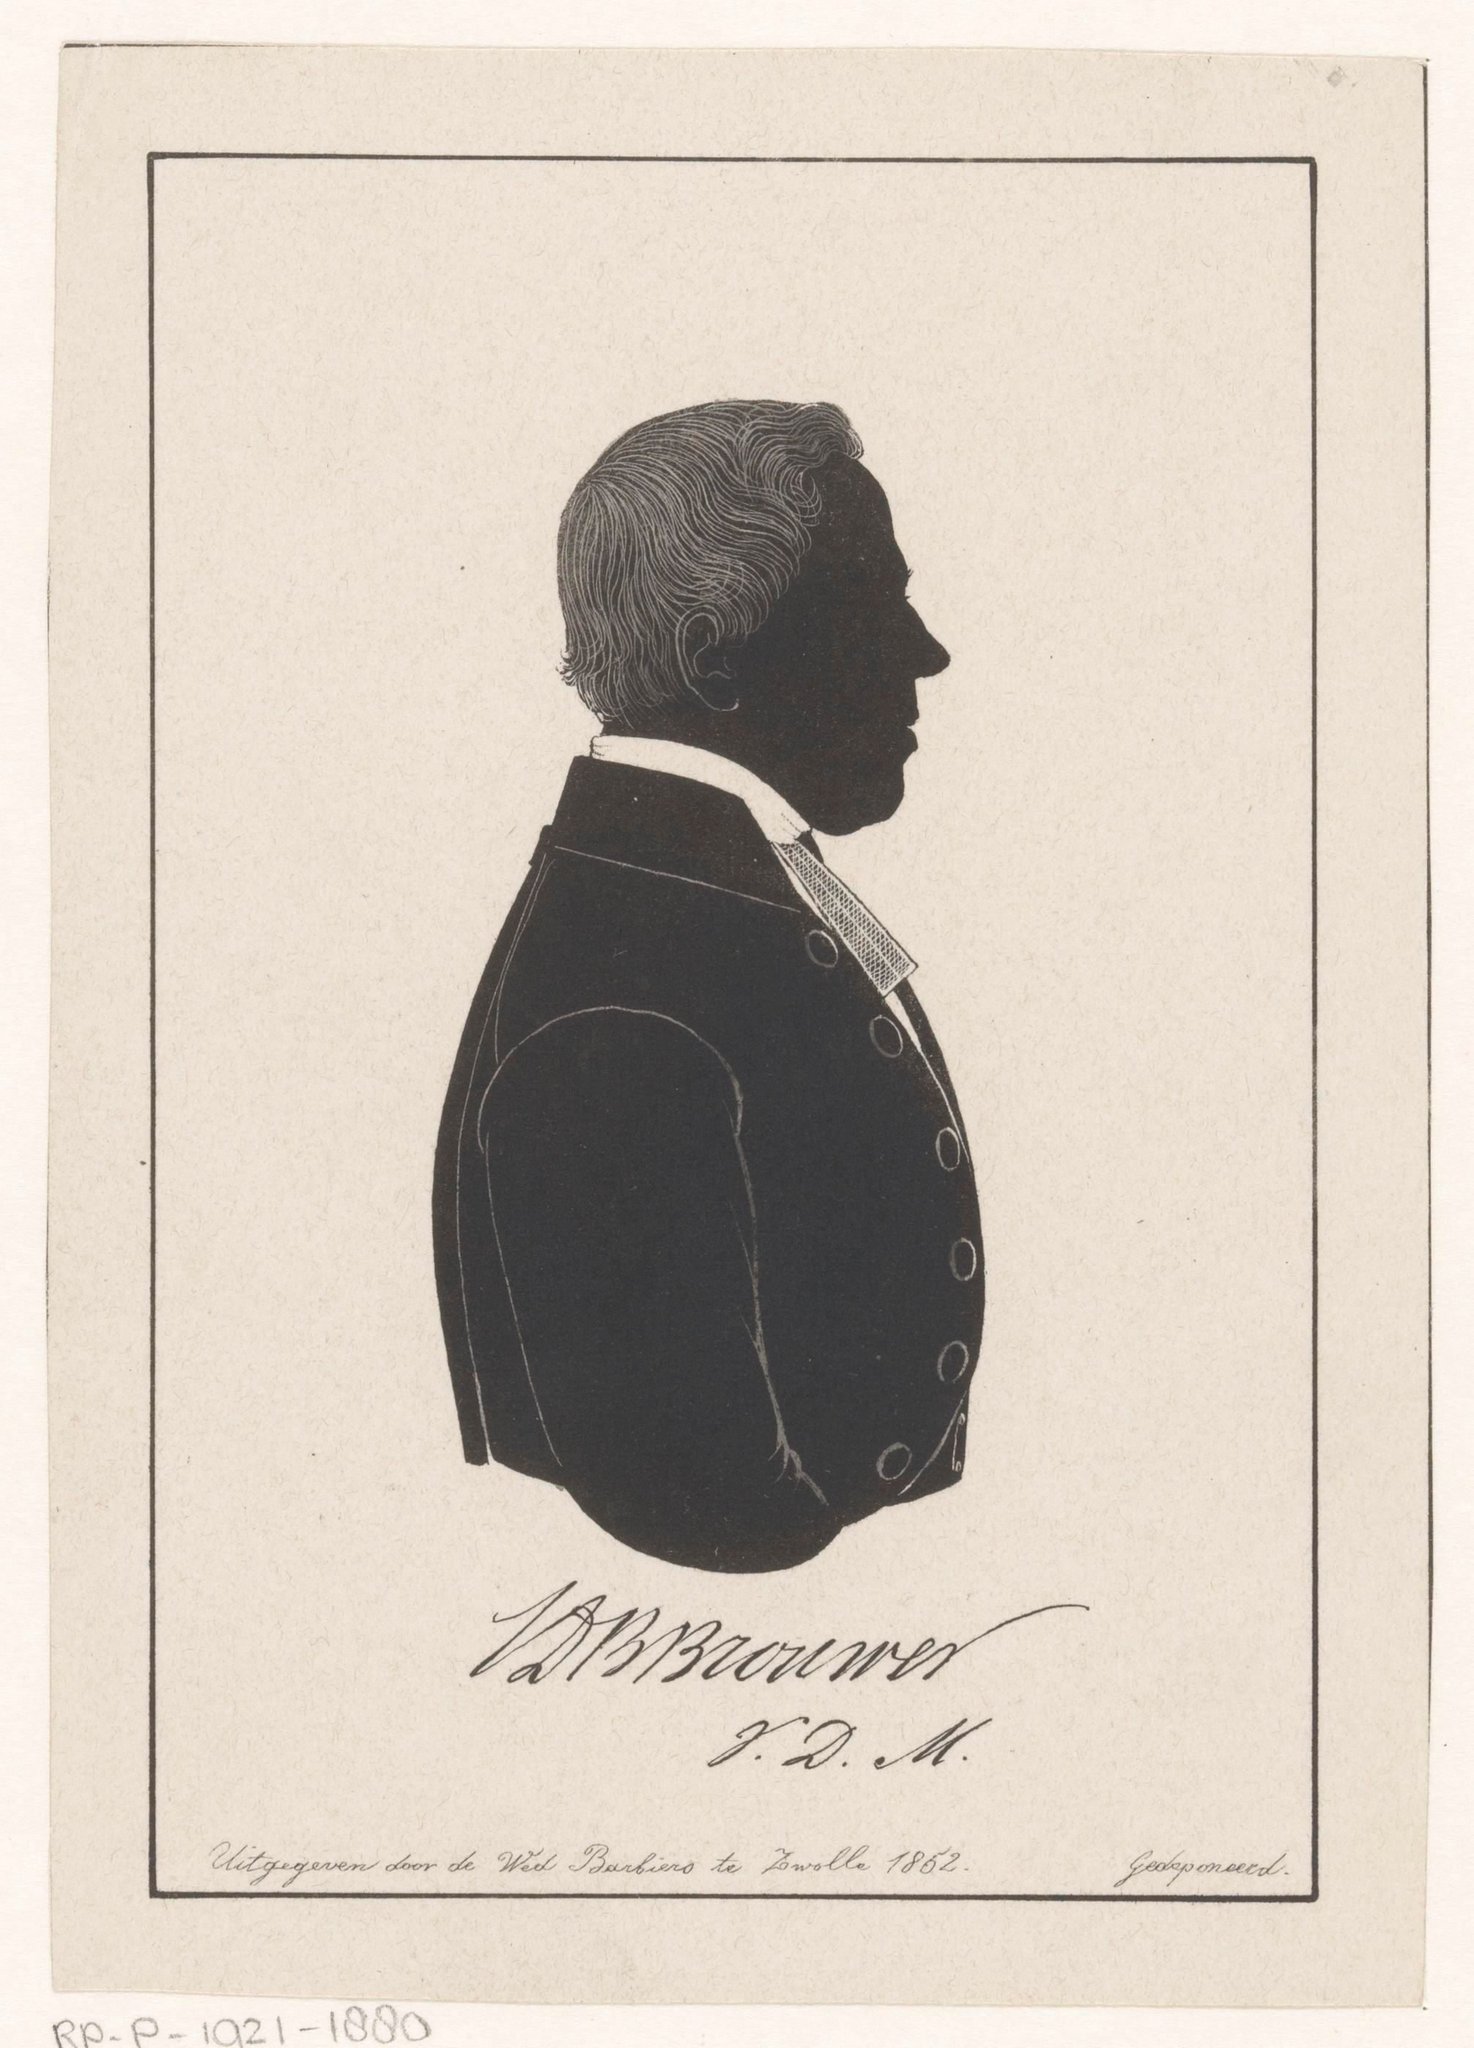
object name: print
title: Silhouetportret van Jan Daniël Beman Brouwer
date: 1852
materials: paper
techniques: hand coloring, lithograph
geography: zwolle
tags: utrecht, leiden, historical persons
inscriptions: collector's mark: Lugt 2228, : ‘Gedeponeerd.’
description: Onder het portret de signatuur van de geportretteerde.